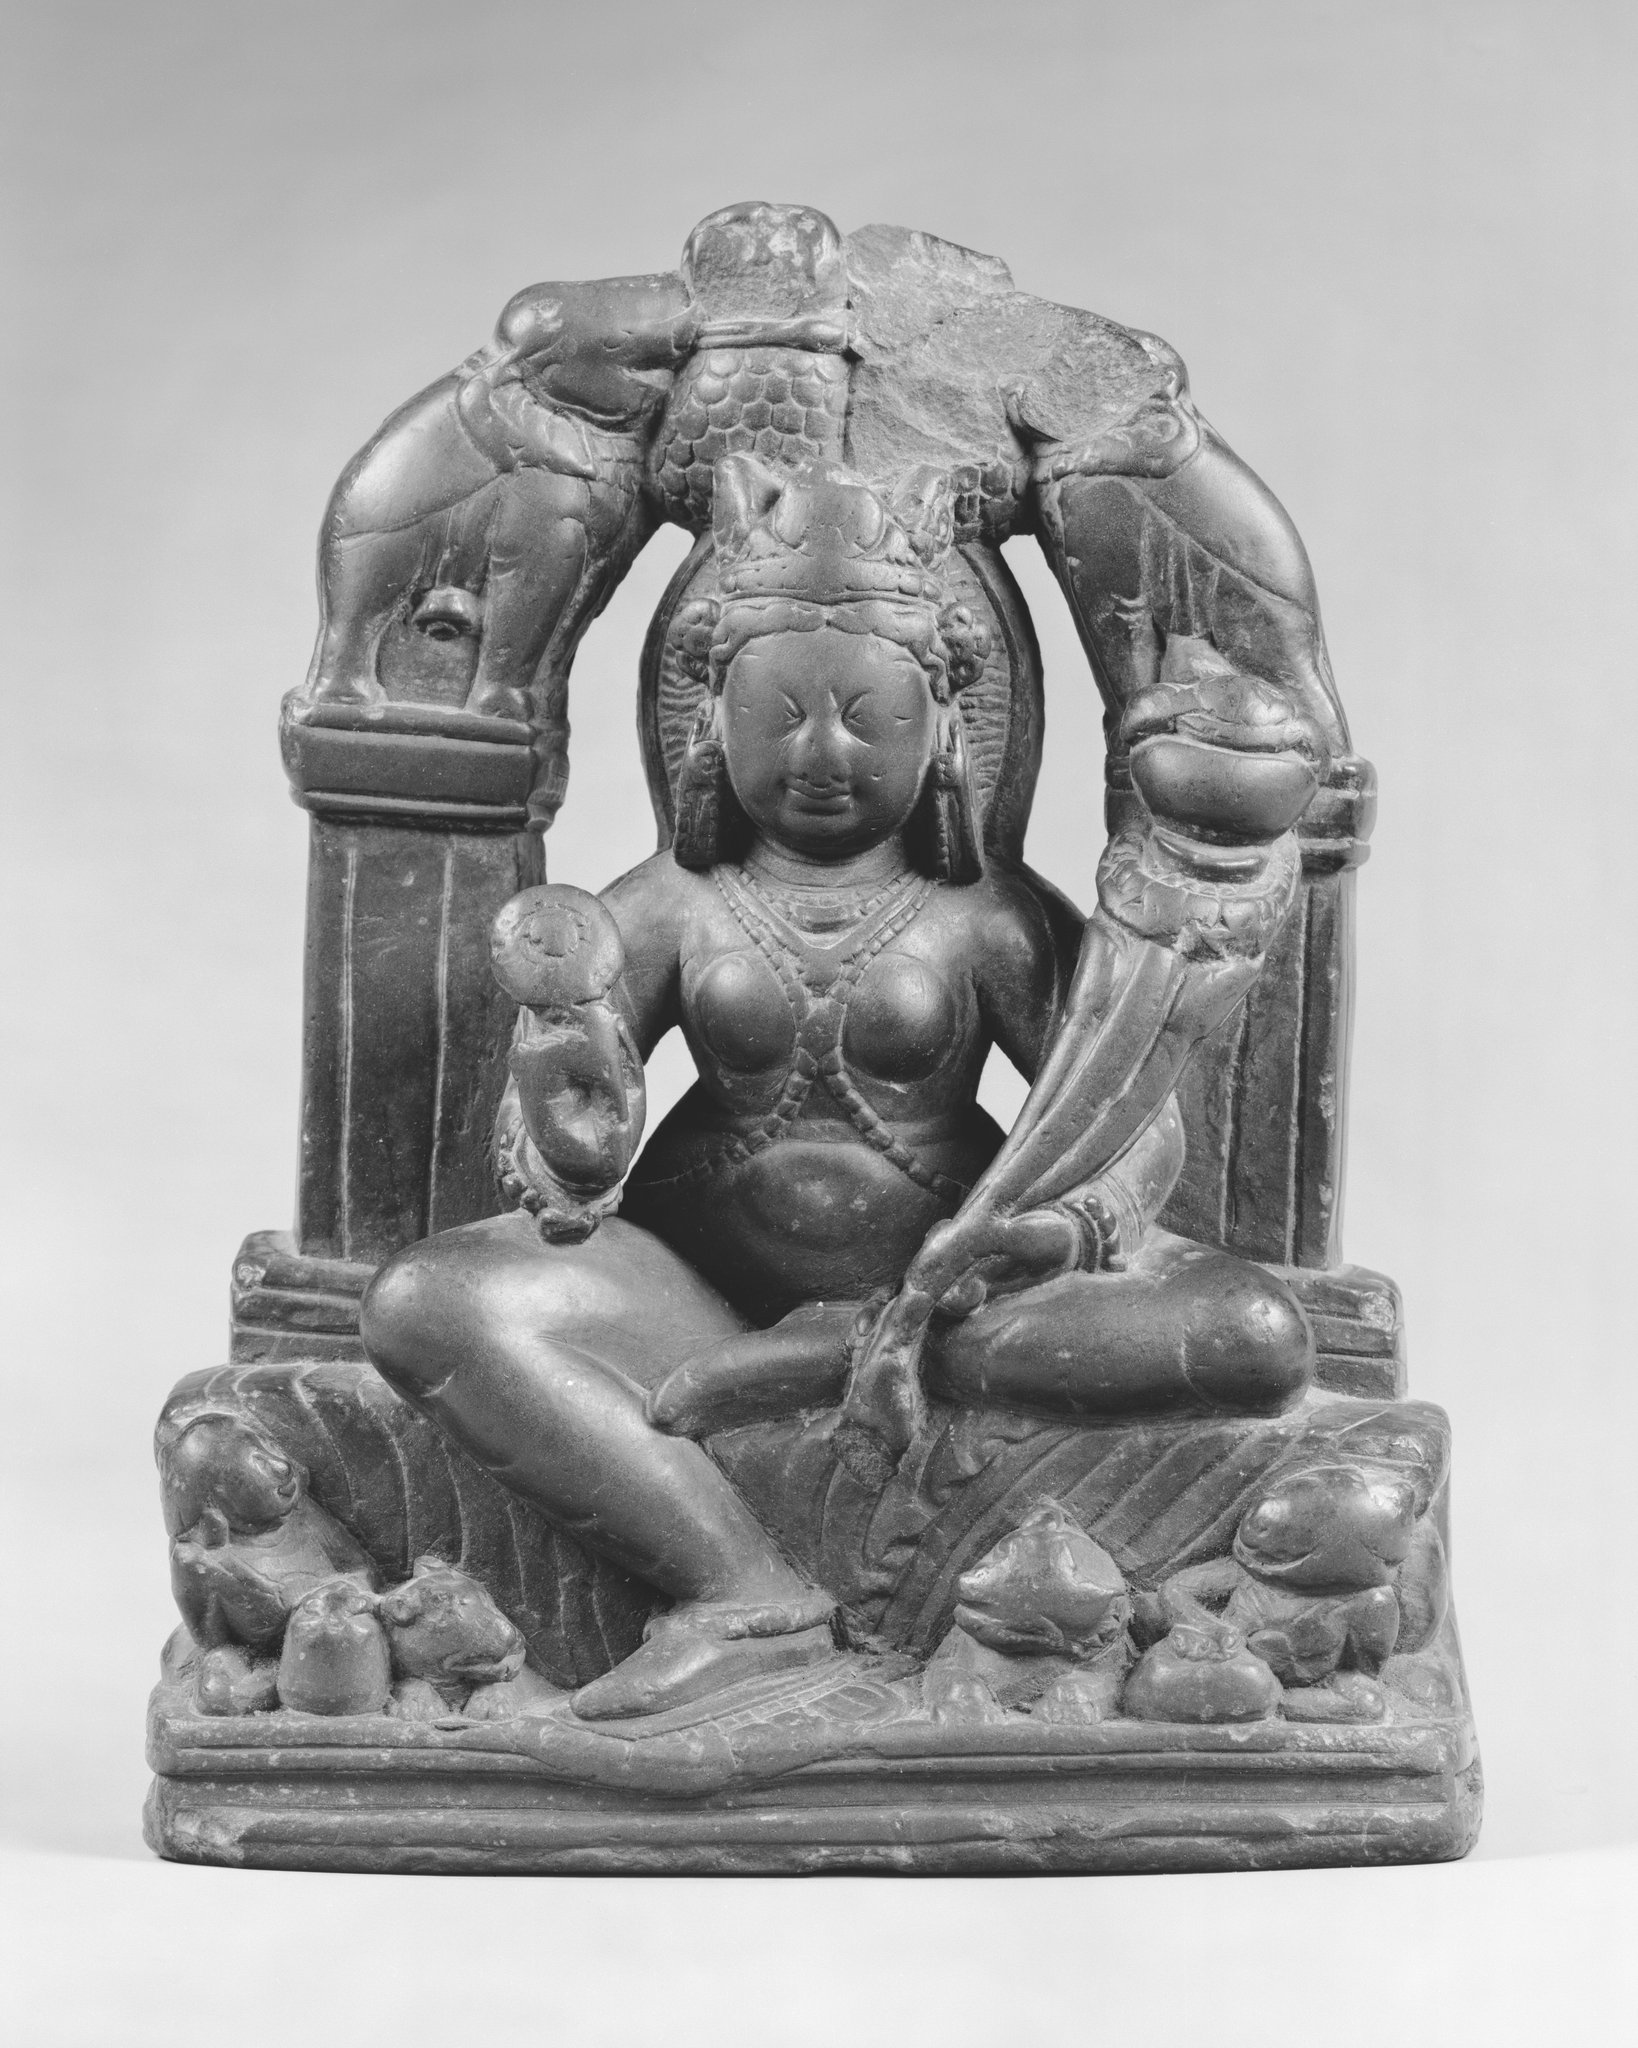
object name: relief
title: Gaja Lakshmi, Goddess of Fortune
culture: kashmiri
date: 701-800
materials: stone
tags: kashmir,goddess